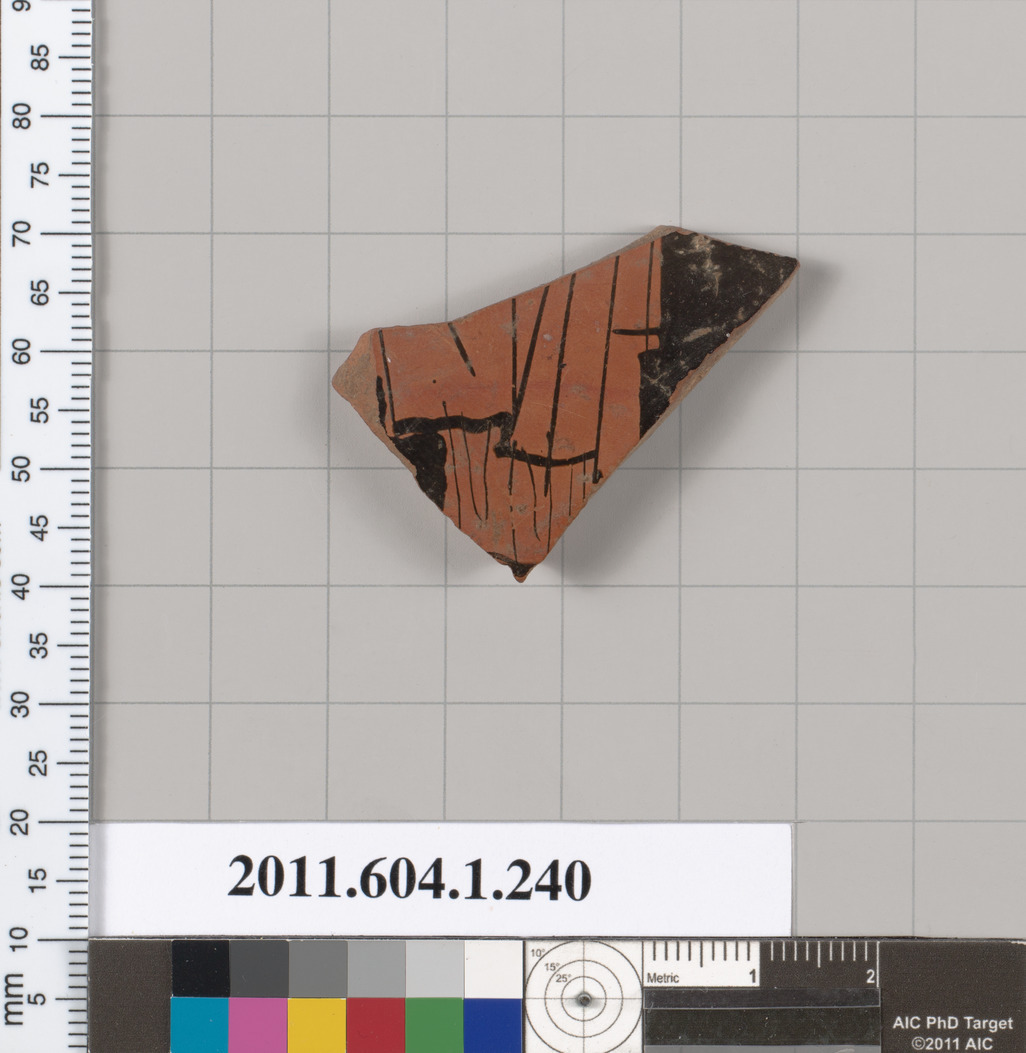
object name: kylix fragment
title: Terracotta fragment of a kylix (drinking cup)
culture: greek, attic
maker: angular painter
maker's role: artist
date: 475-451 BCE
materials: terracotta